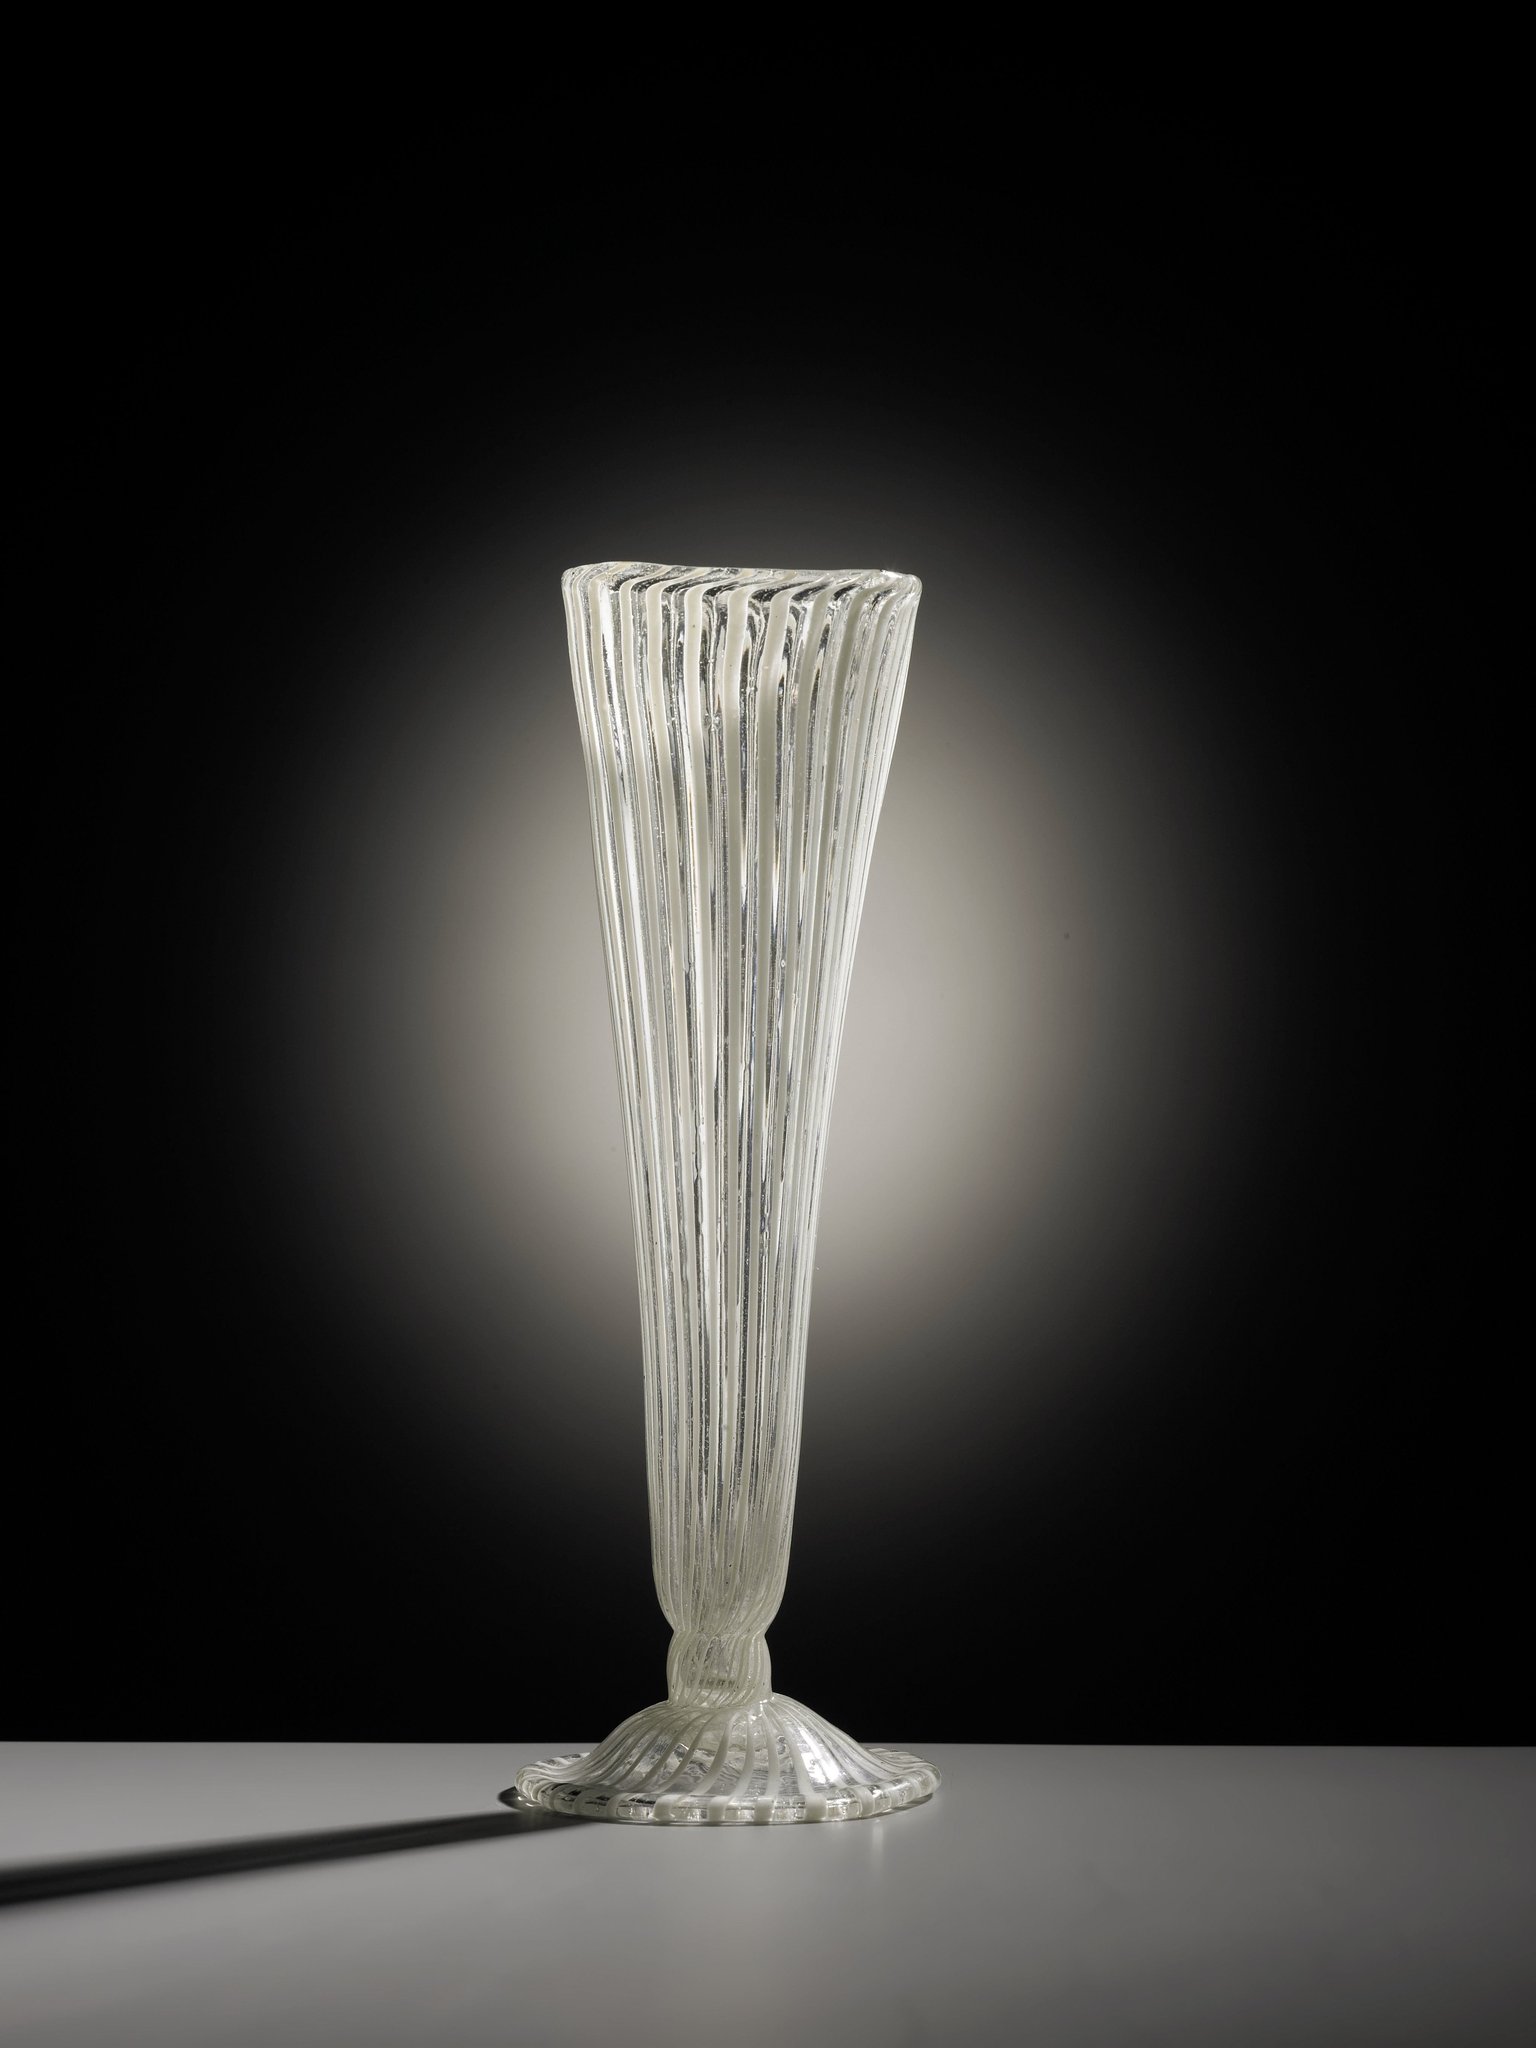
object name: flute glass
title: Fluitglas van filigraanglas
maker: Anonymous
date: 1600-1700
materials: glass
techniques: façon de venise, filigree glass, glassblowing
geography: western europe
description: Lage, gewelfde voet met omgeslagen rand. Stam gevormd door een holle nodus. Trechtervormige kelk. Voet, stam en kelk met verticale, ingesmolten lattimo draden.